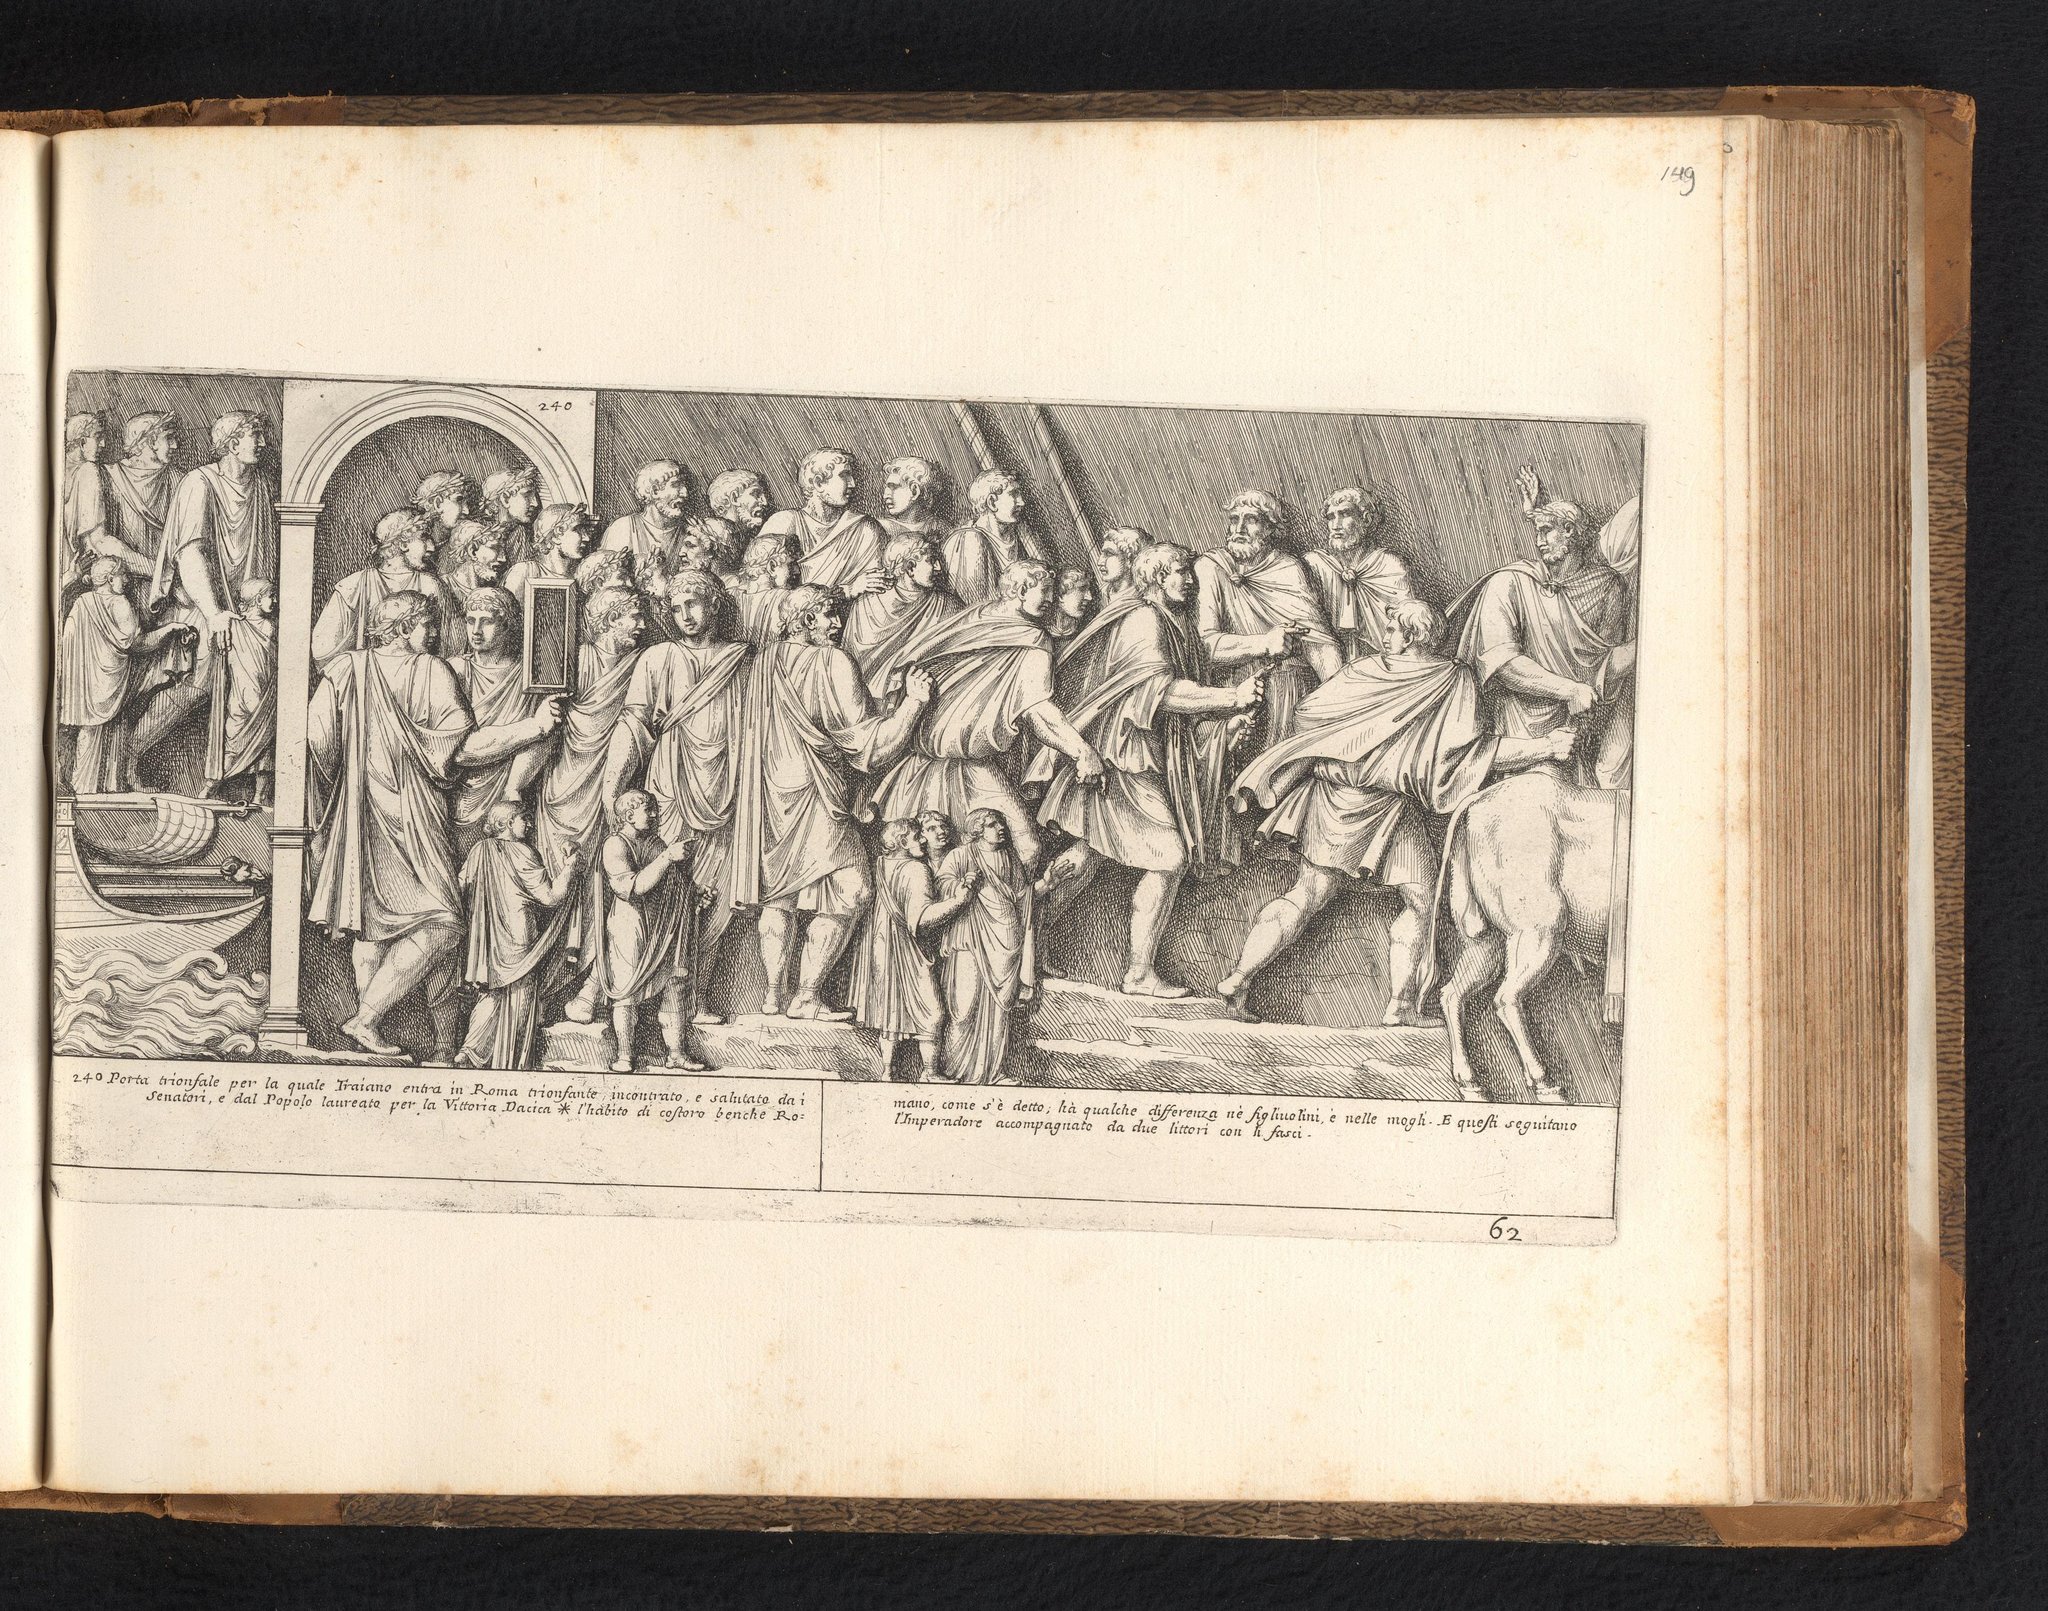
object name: album leaf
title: Colonna Traiana eretta dal senato, e popolo Romano all' imperatore Traiano Augusto nel suo foro in Rom (...)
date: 1637-1691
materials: paper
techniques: etching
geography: rome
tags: triumphal column with helical friezes, piece of sculpture, reproduction of a piece of sculpture, the soldier; the soldier's life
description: Detail van het spiraalvormige gebeeldhouwde fries op de Zuil van Trajanus. Het fries toont de oorlogen tussen de Romeinen en de Daciërs. Verklarende nummers in de ondermarge. Prent maakt deel uit van een album.